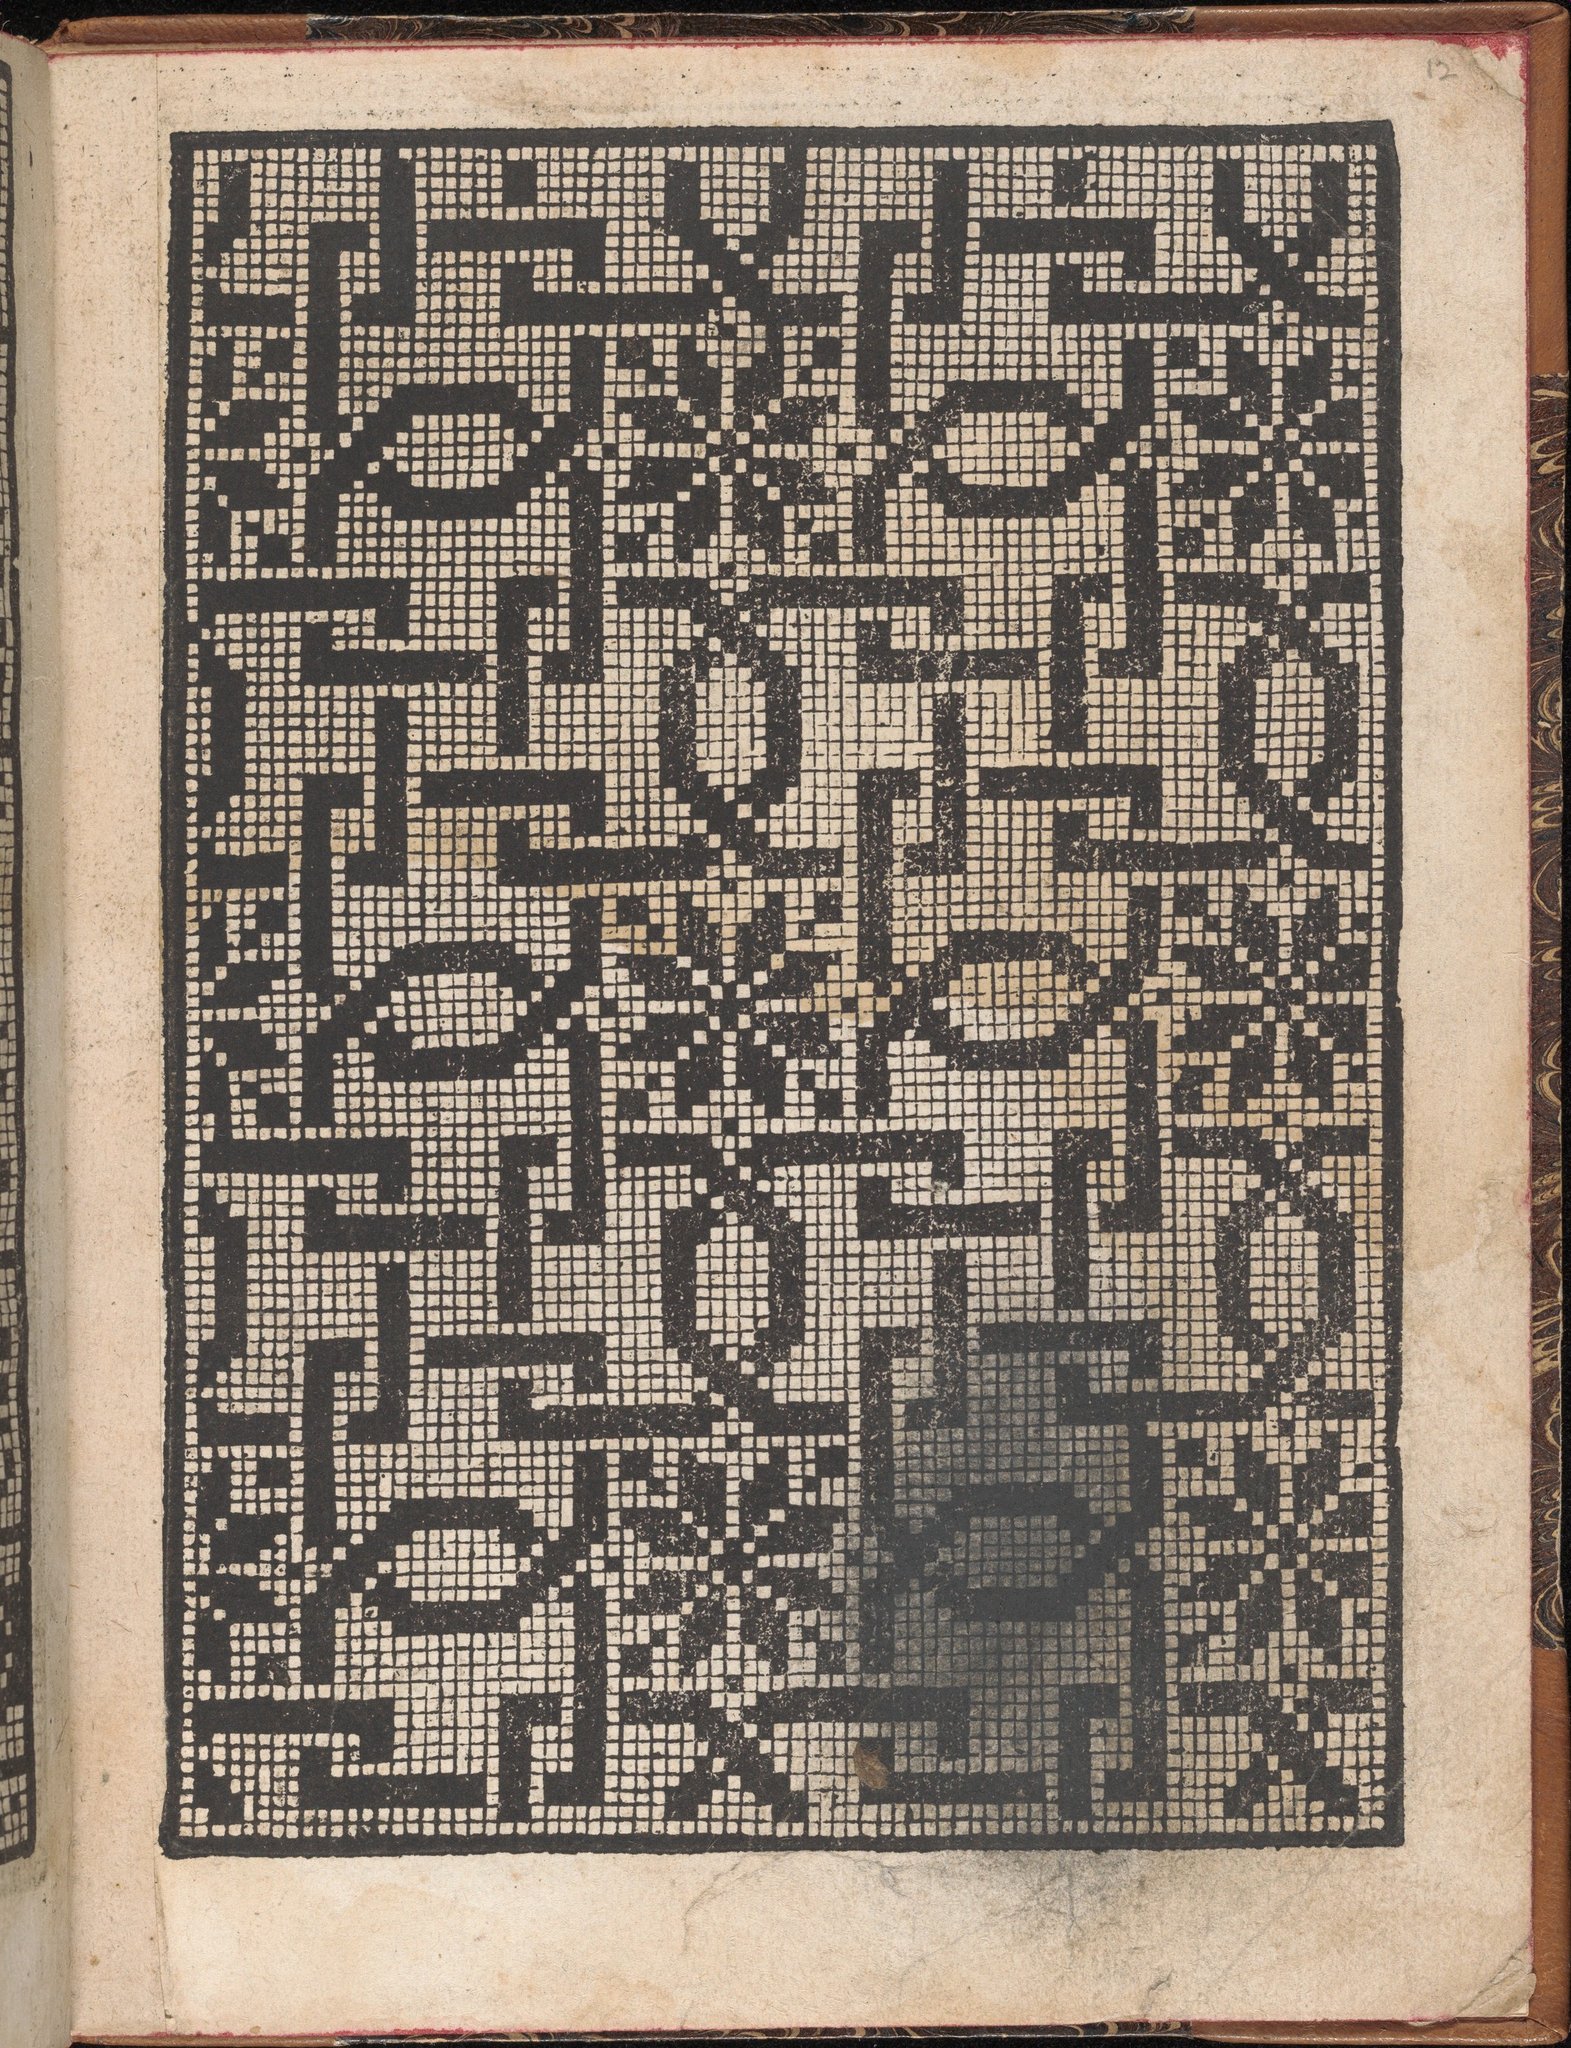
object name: book print ornament architecture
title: Spechio di pensieri delle belle et Virtudiose donne, page 11 (recto)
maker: matteo pagano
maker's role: publisher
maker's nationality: italian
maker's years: 1515-1588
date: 1546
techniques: woodcut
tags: ornament